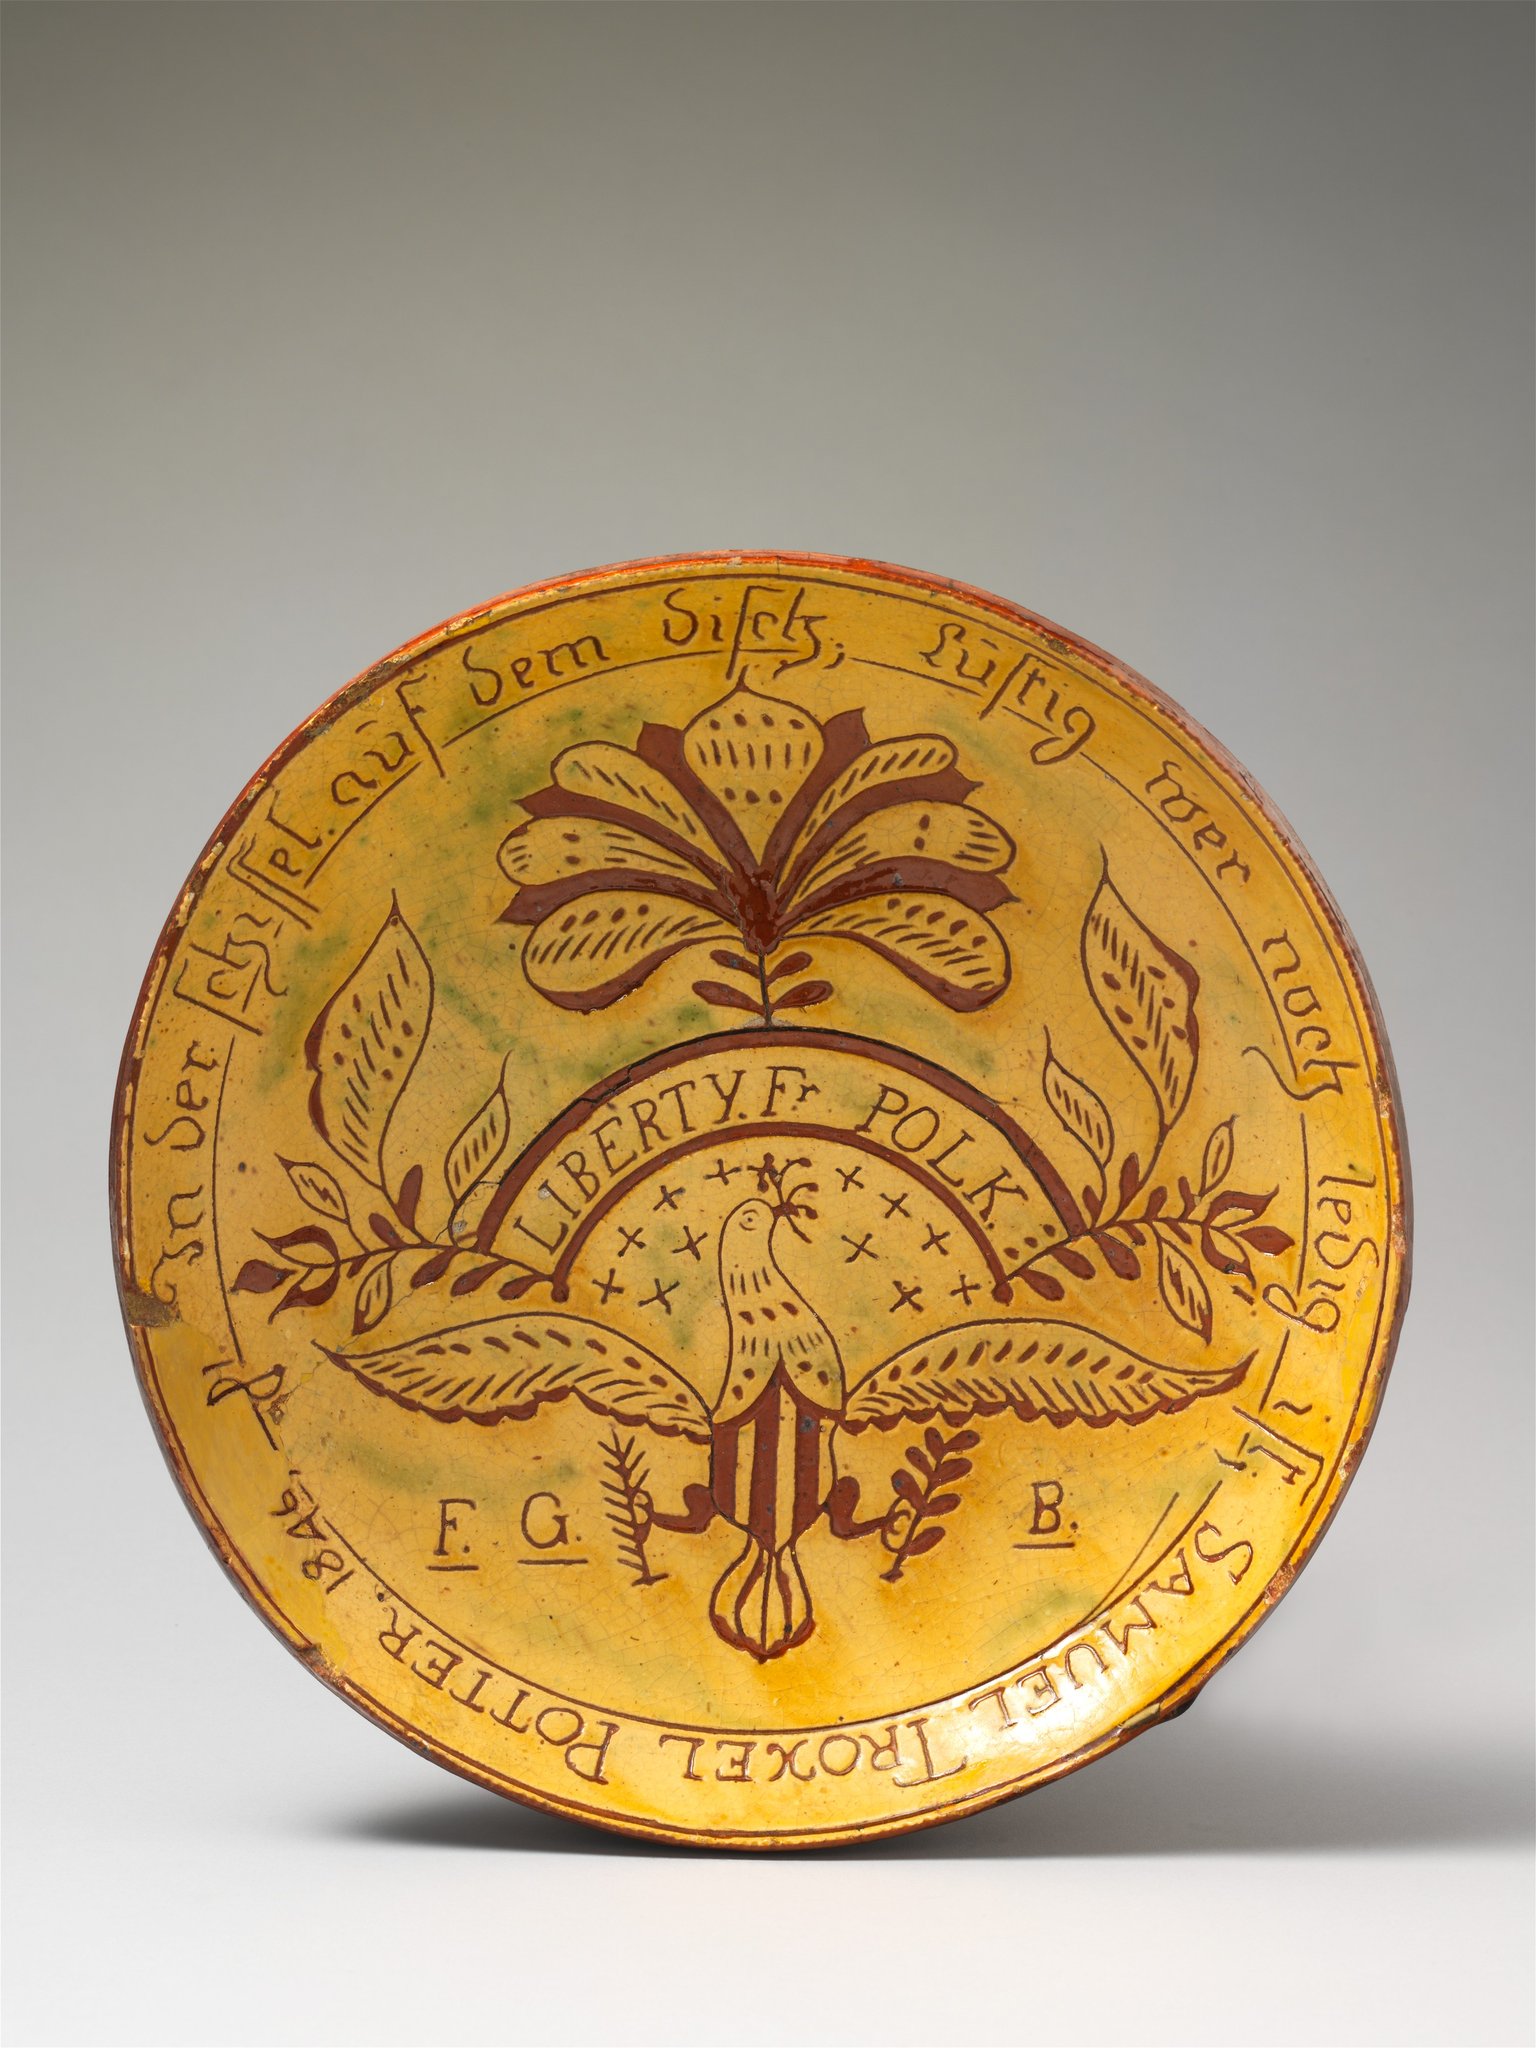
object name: plate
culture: american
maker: samuel troxel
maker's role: maker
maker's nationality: american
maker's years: 1803-1870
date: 1846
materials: earthenware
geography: united states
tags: eagles